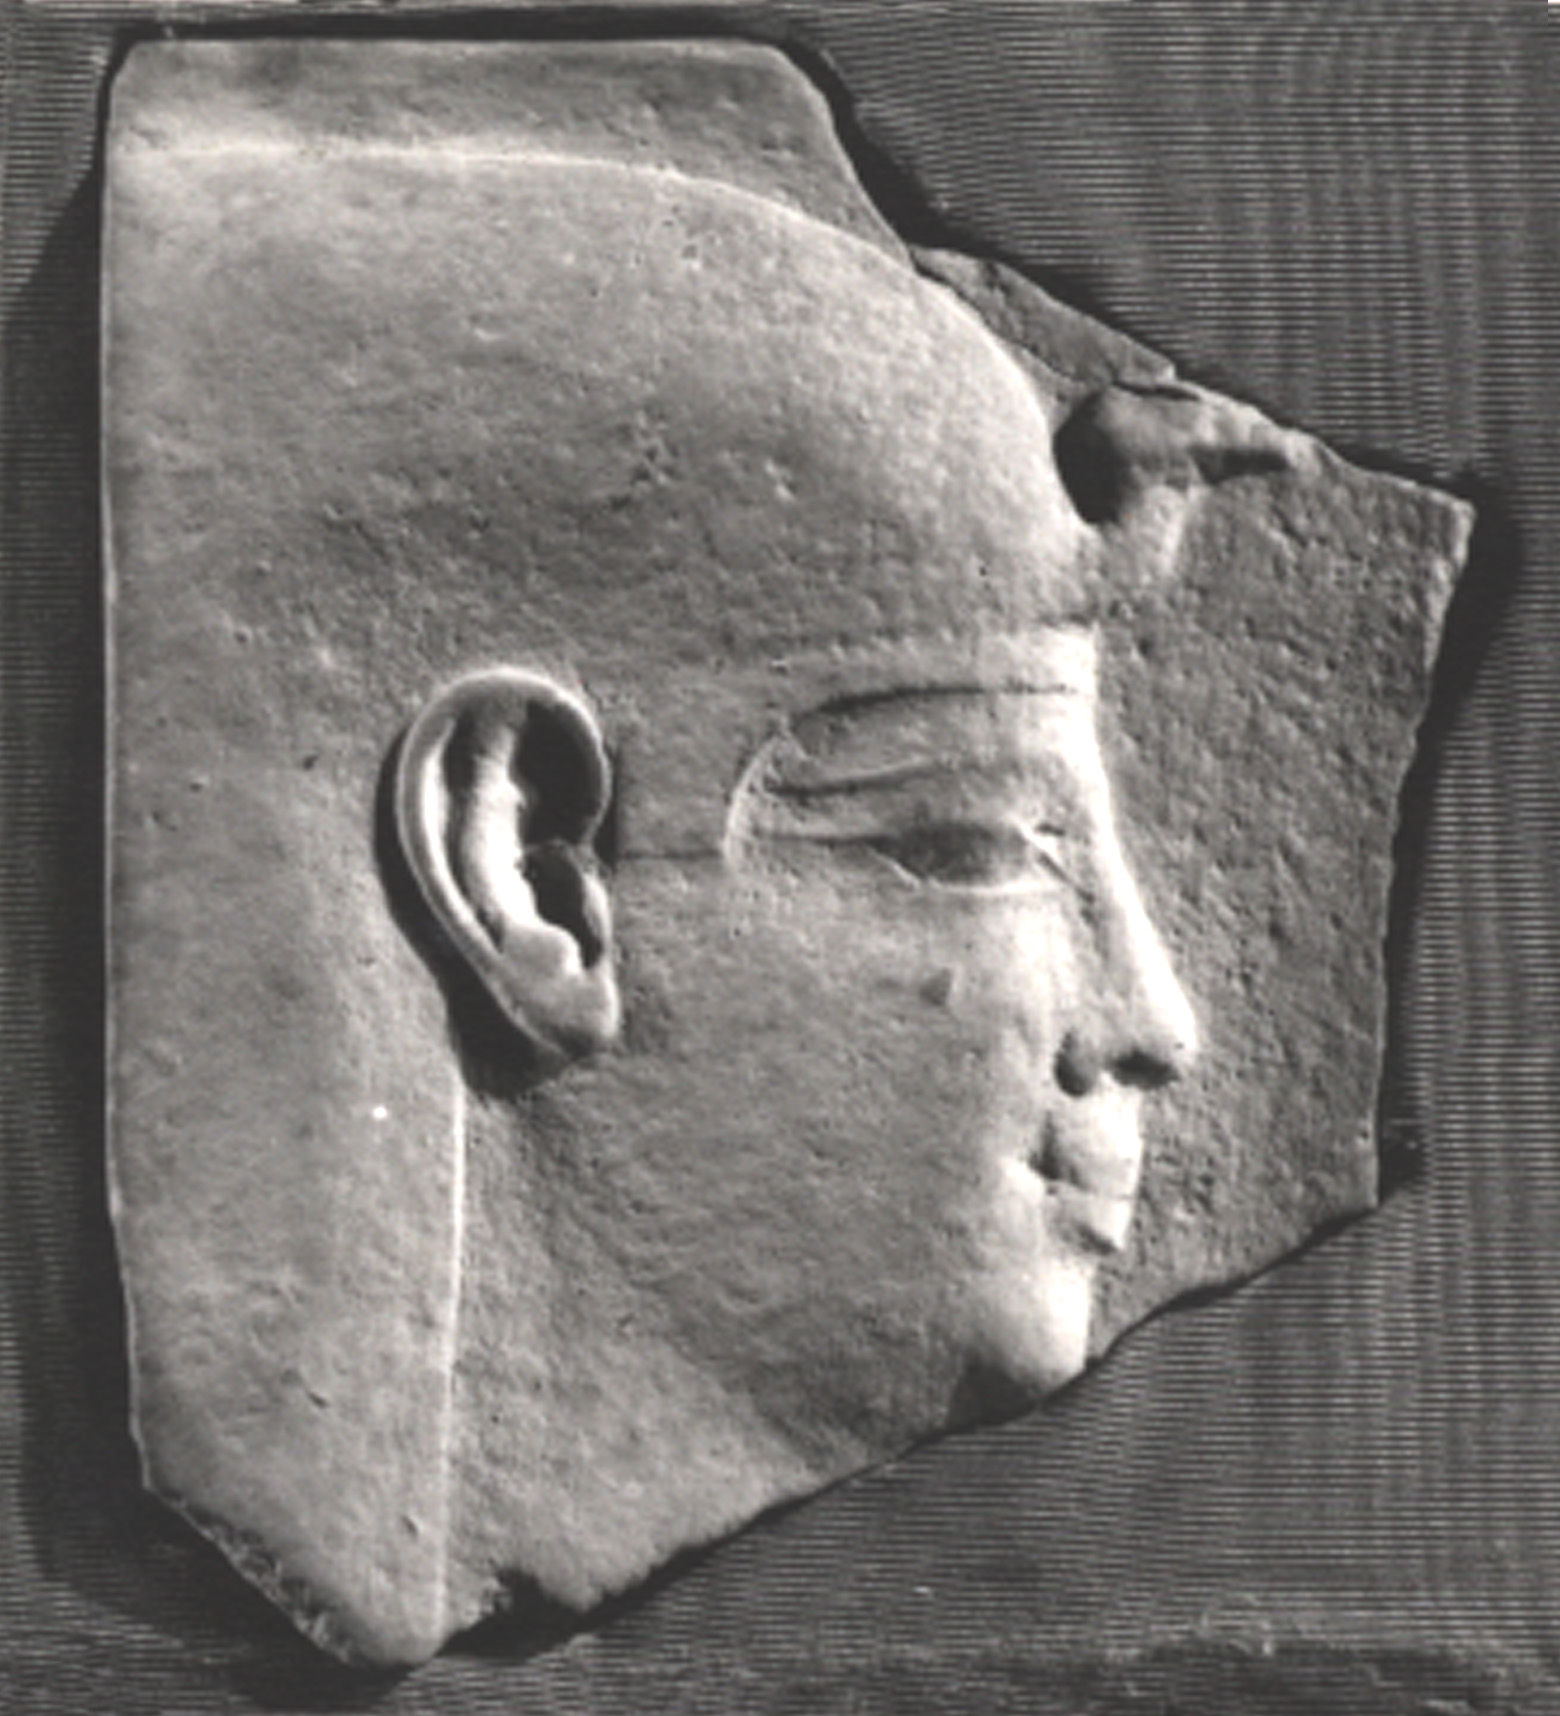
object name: sculptor's model votive, relief, head, goddess, queen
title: Relief plaque with Head of a Goddess or Queen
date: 400-200 BCE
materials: limestone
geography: egypt